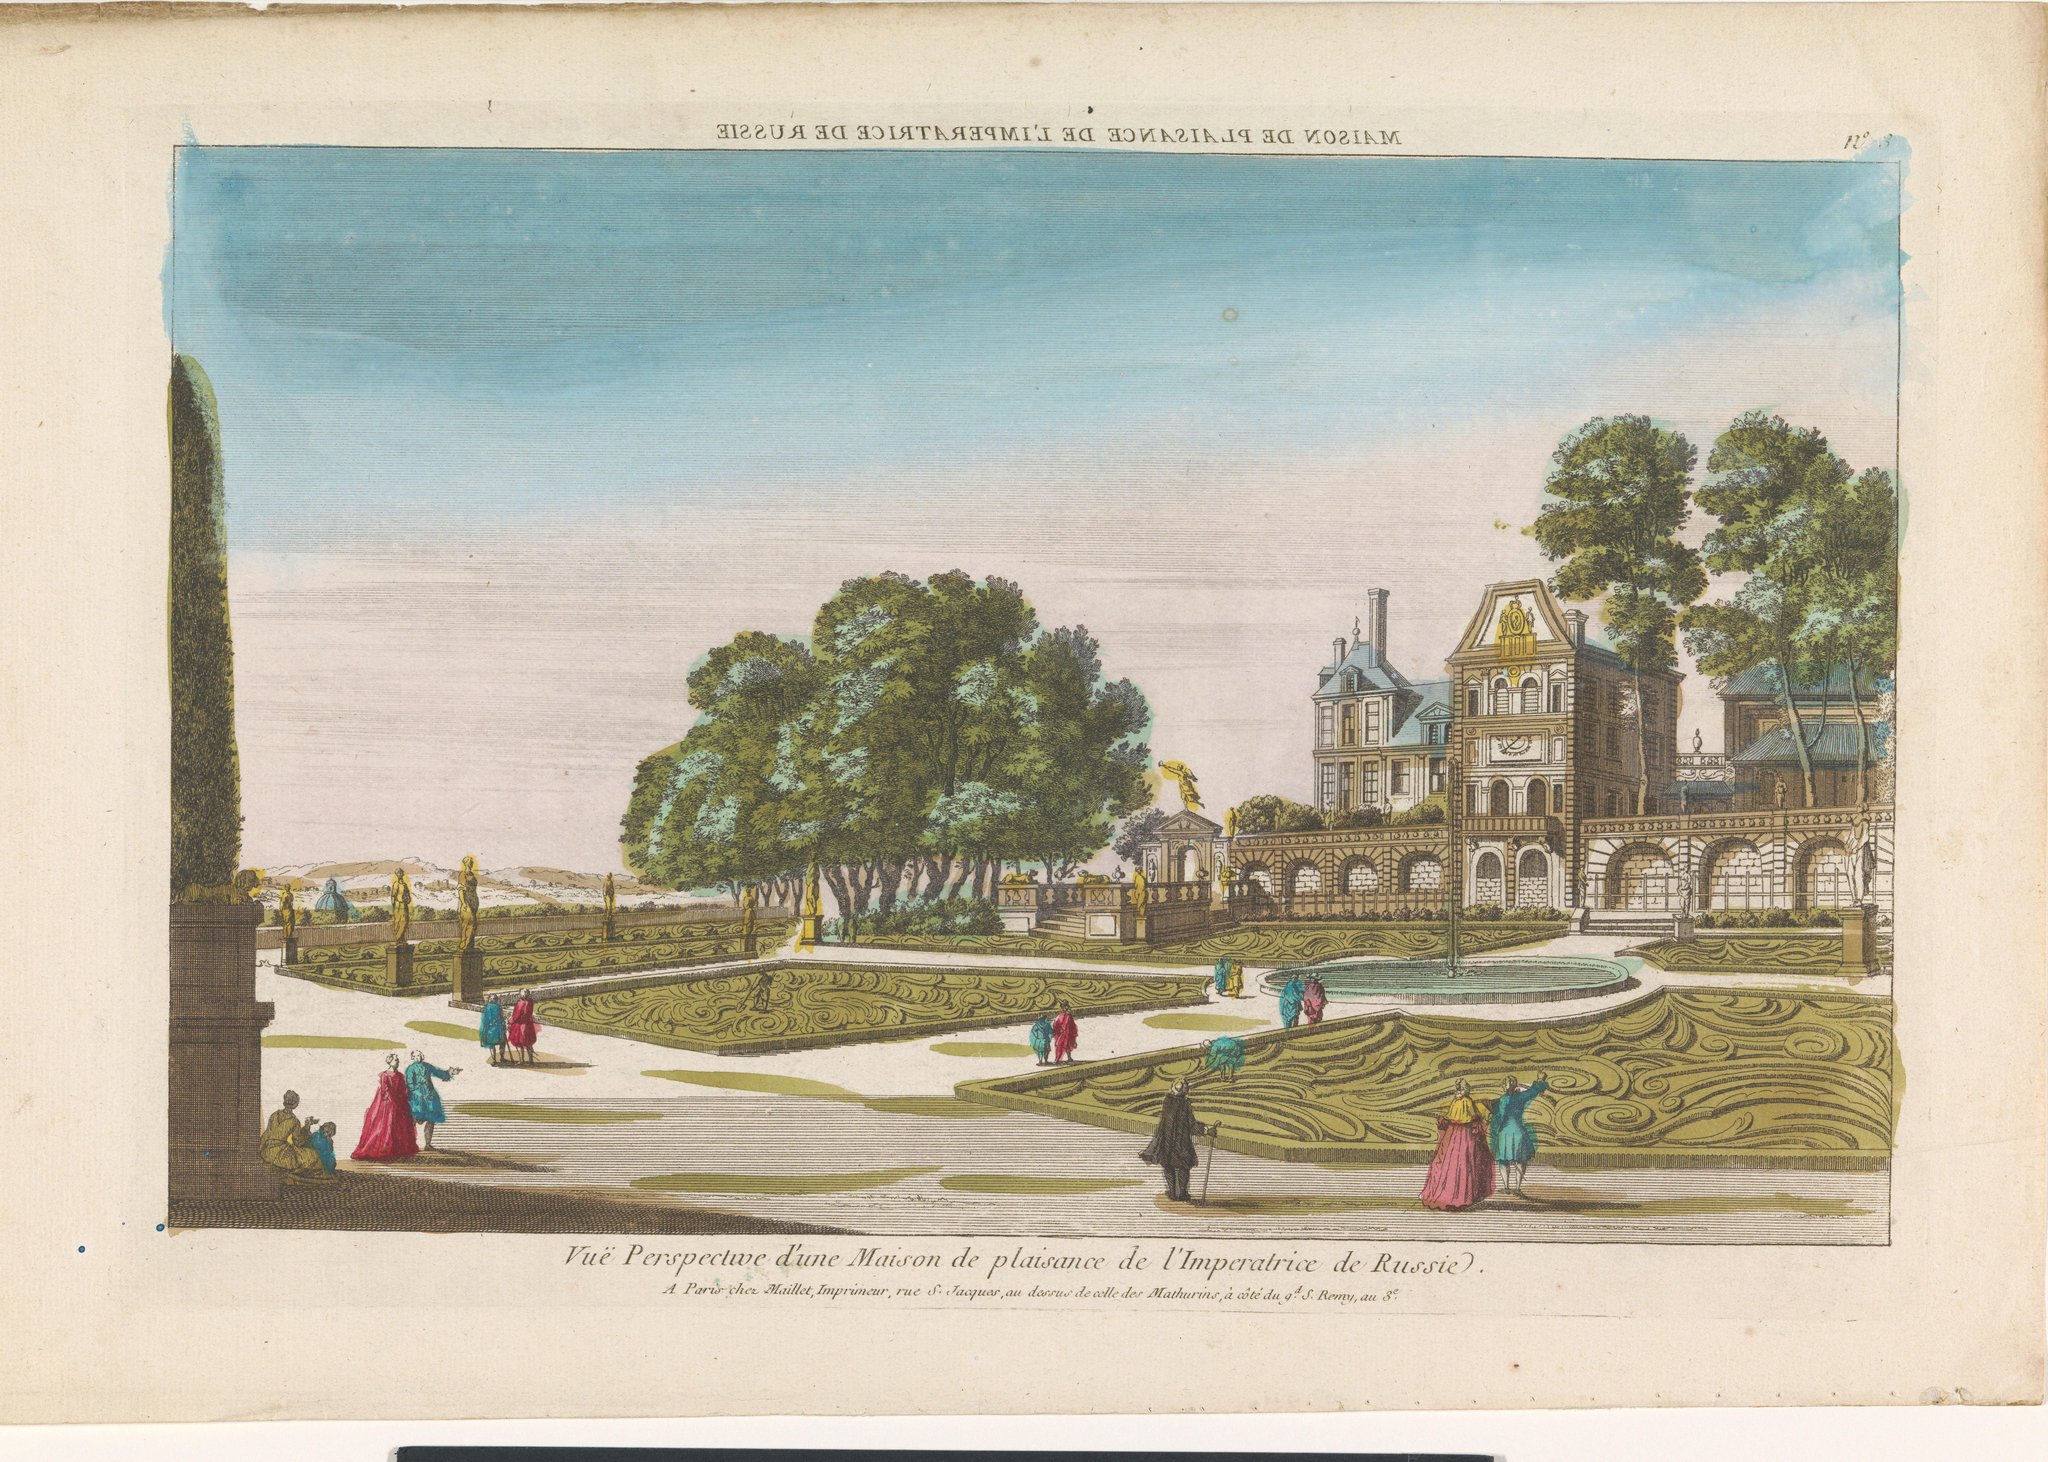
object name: opticaprent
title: Maison de plaisance de l'imperatrice de Russie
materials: paper, watercolor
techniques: brush, etching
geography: paris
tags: garden, garden fountain, ornamental plants, garden ornaments, country-house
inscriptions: watermark, collector's mark: Lugt 2166